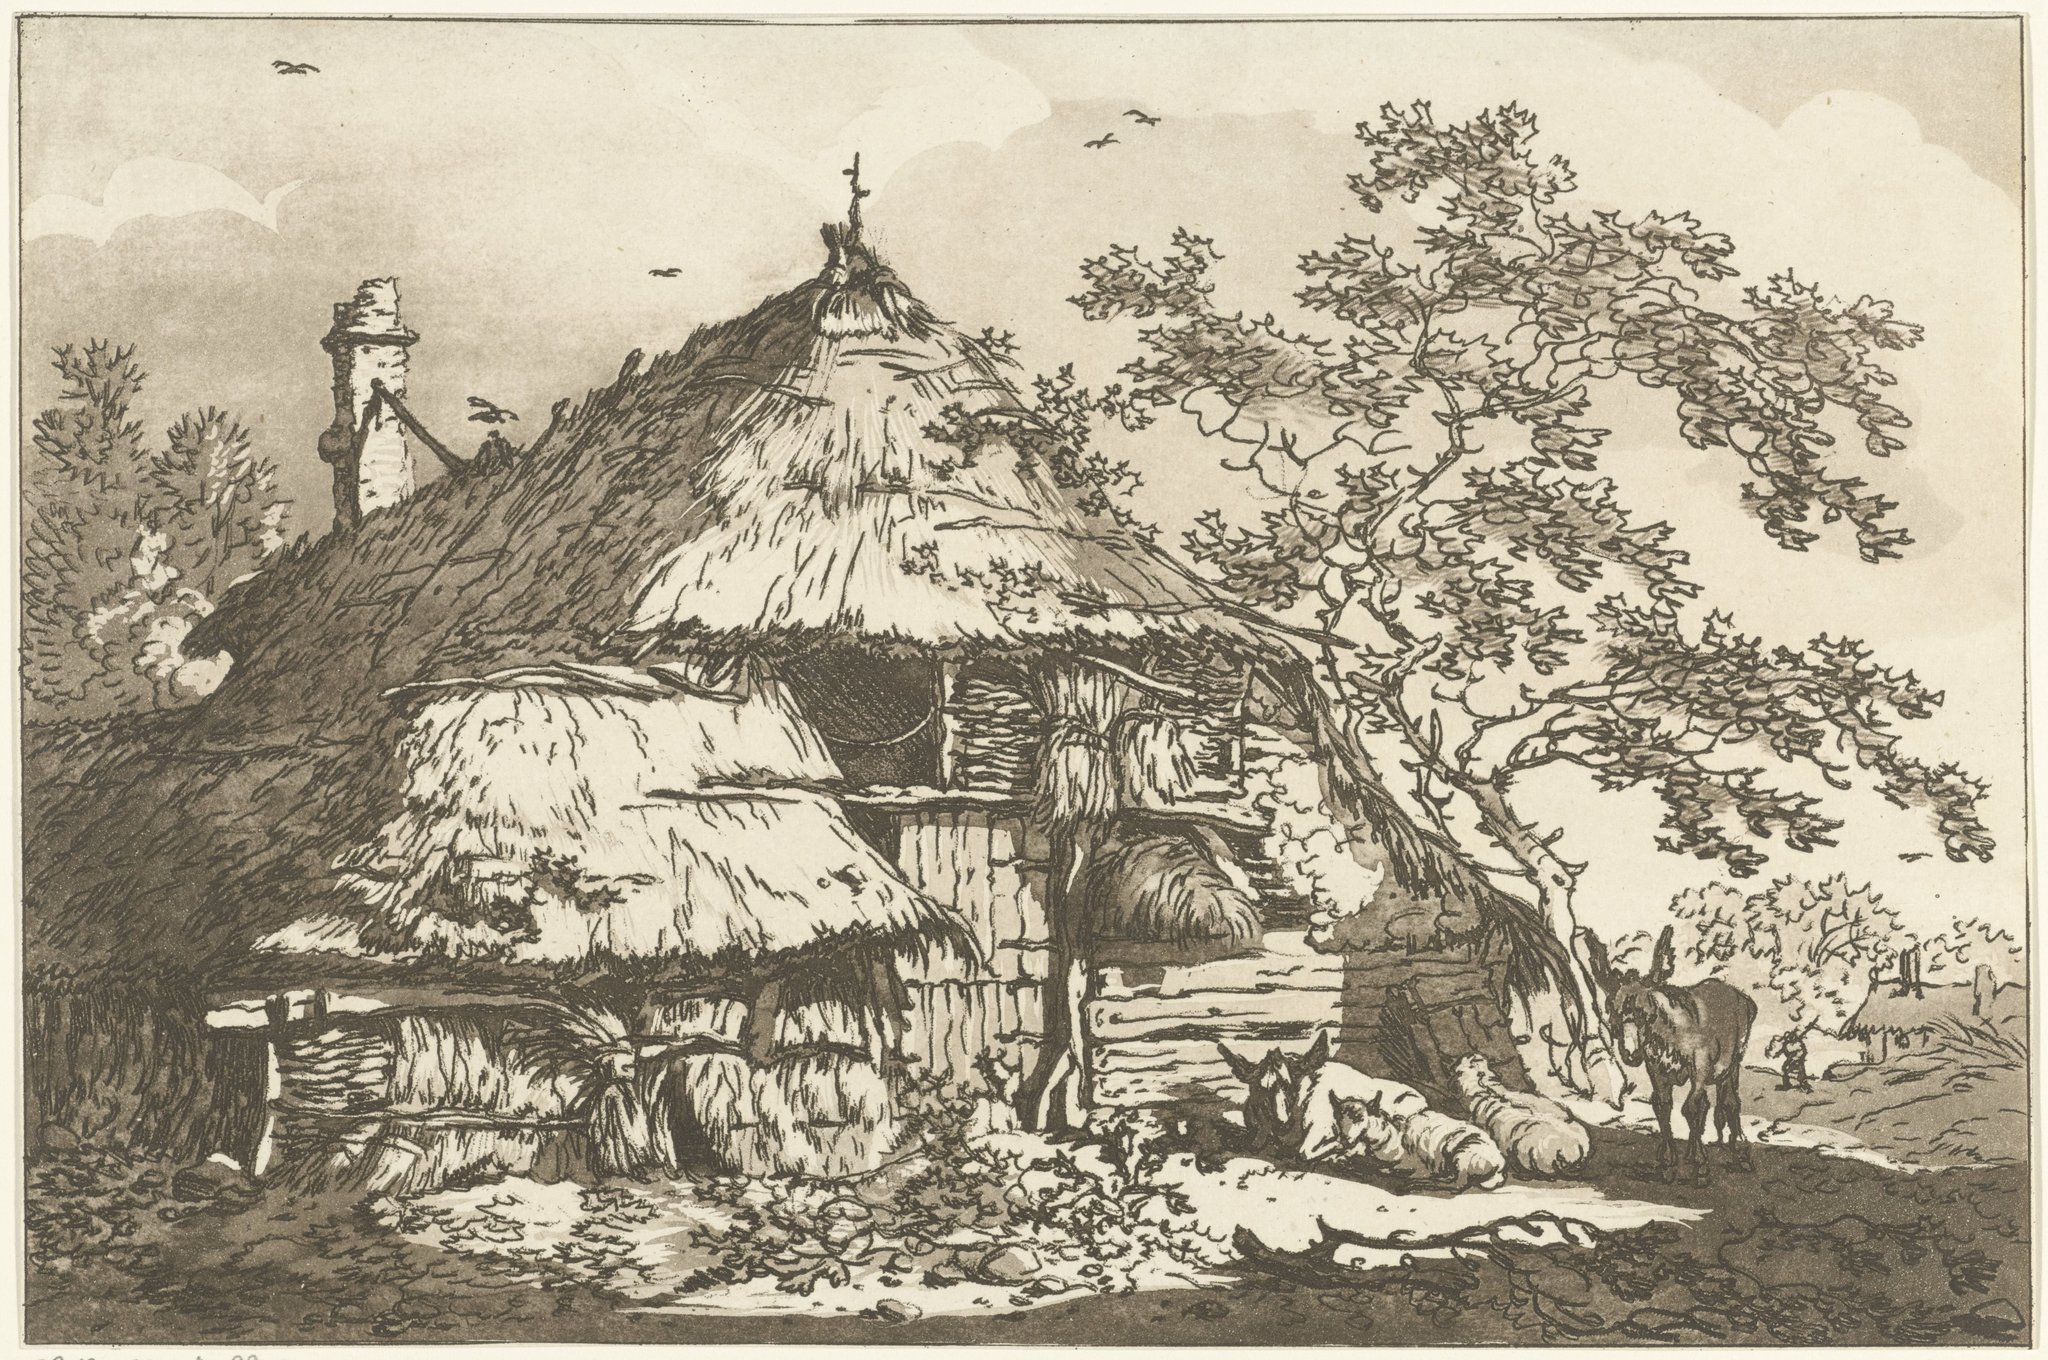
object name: print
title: Twelve designs Calculated for the Use of those who are Learning to Draw Landscape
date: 1789-1793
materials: paper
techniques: aquatint, etching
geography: london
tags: ass, donkey, sheep, farm or solitary house in landscape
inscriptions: collector's mark: Lugt 2228